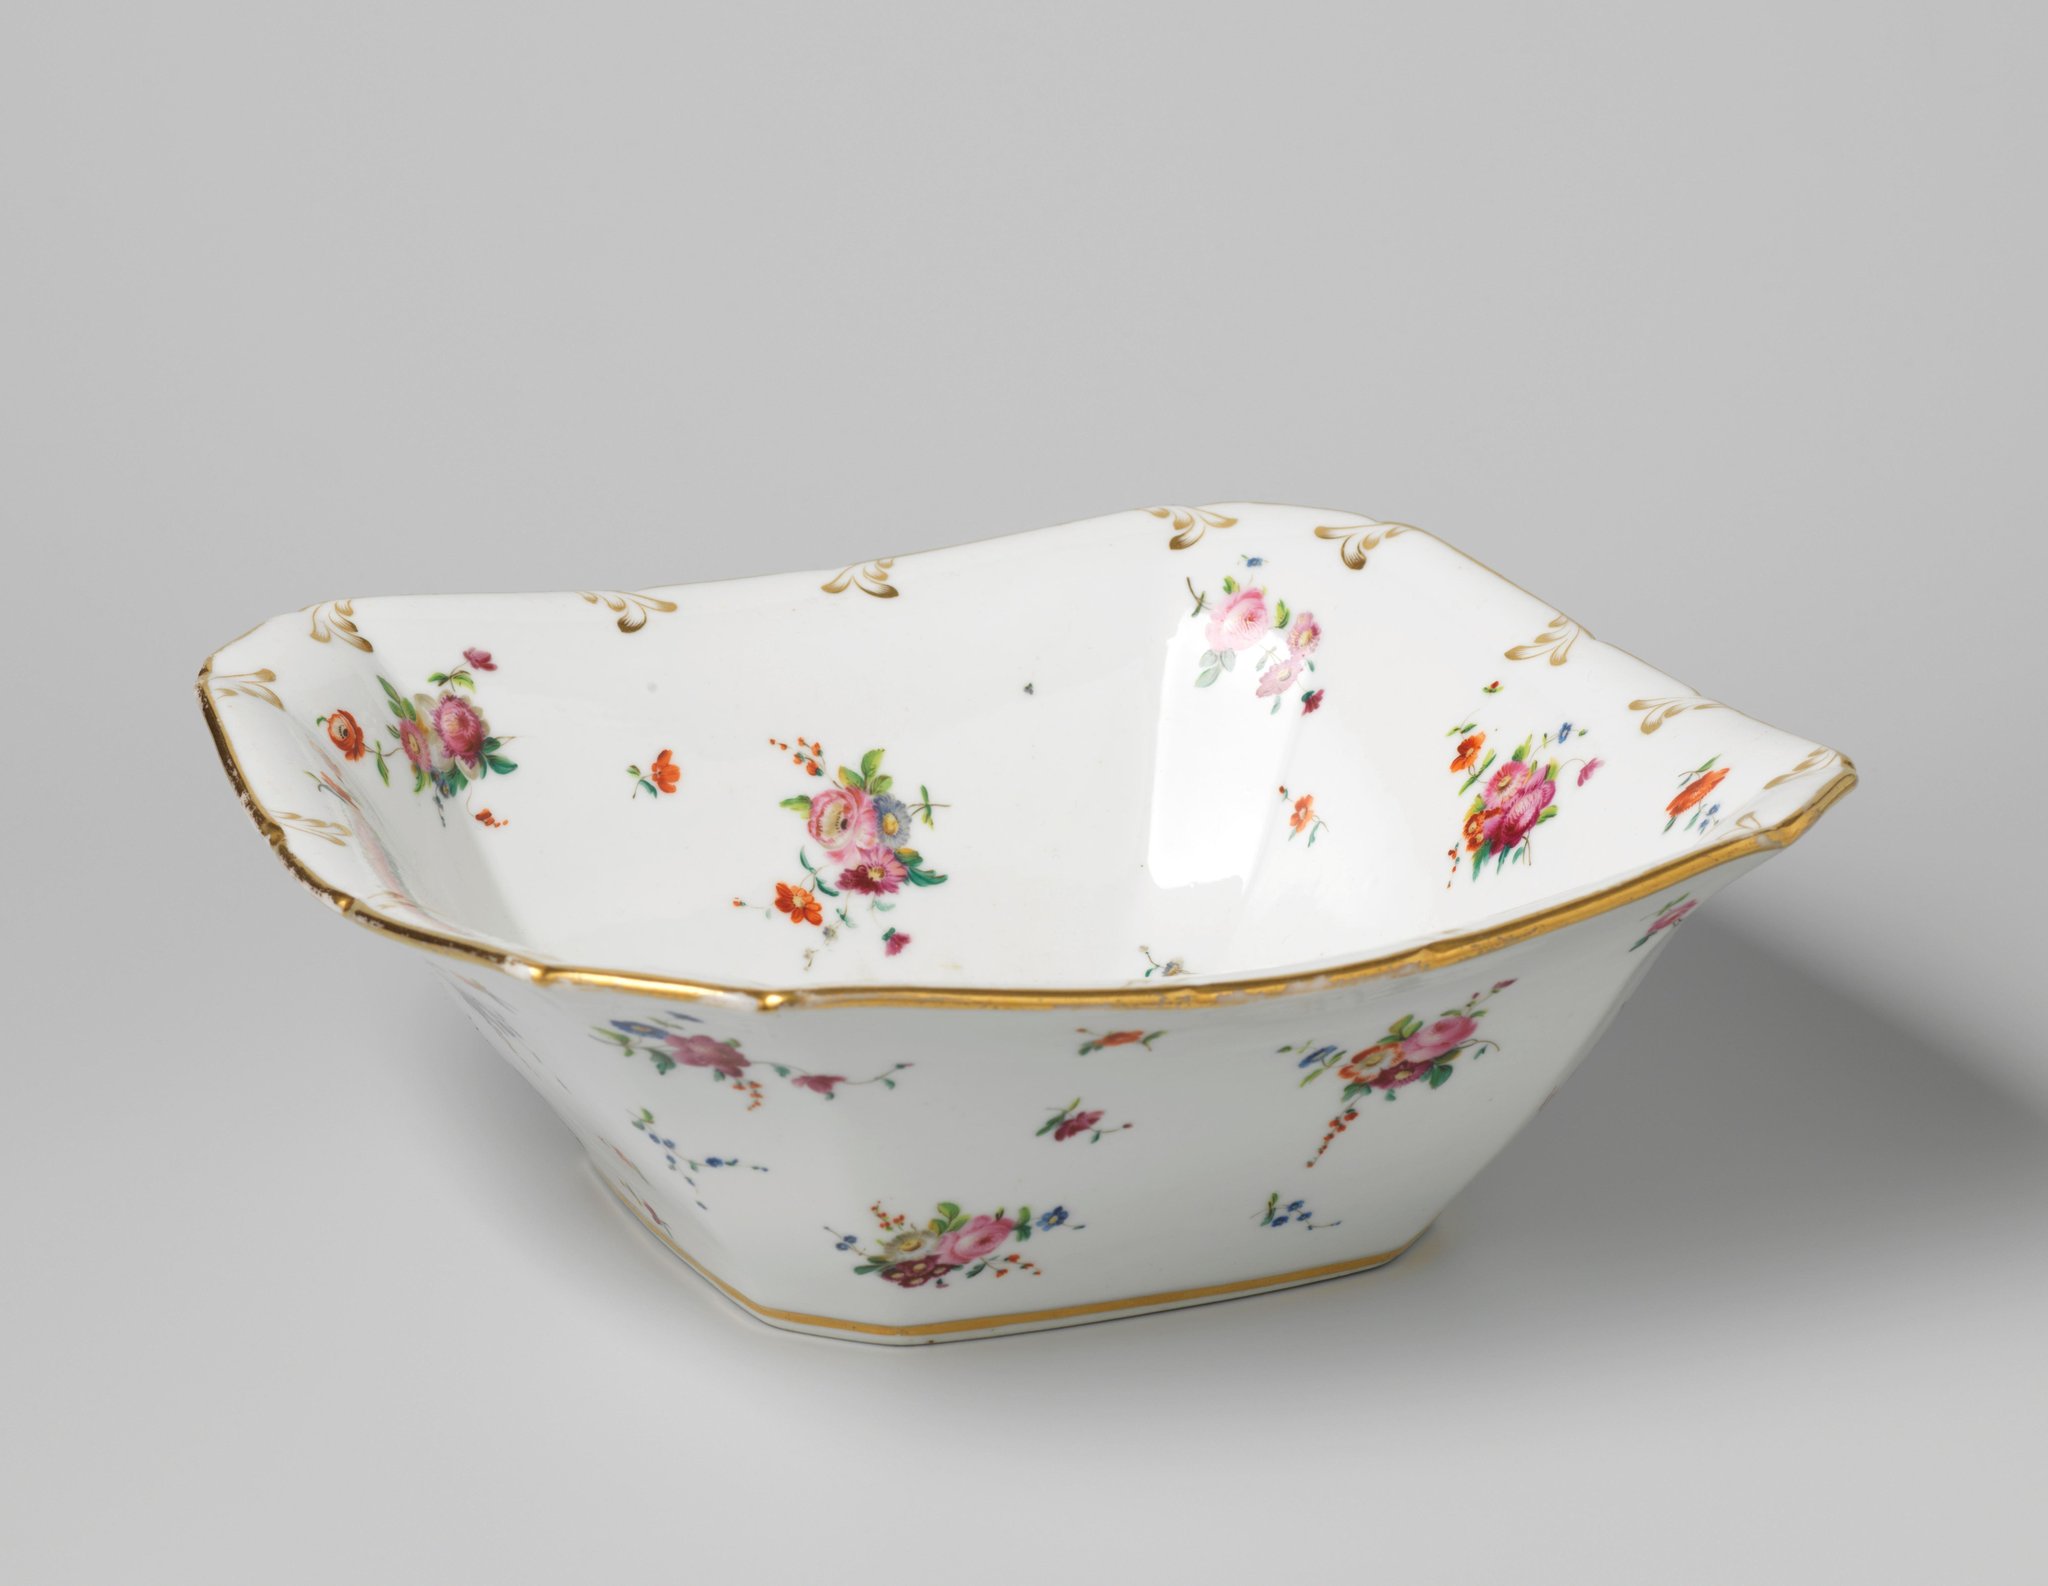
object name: dish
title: Dish with bouquets and flower sprays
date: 1839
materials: glaze, gold, paint, porcelain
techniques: firing, forming, gilding, turning, vitrification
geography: paris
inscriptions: mark: ‘DENUELLE/ Boulevard St. Denis 18/ à Paris’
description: Vierkante schaal van porselein met een gelobde rand en afgeschuinde hoeken, beschilderd op het glazuur in blauw, rood, roze, groen, geel, paars, zwart en goud. Op de binnen- en buitenzijde versierd met boeketten van verschillende bloemen en strooibloemen. Vanuit de gelobde, gouden rand, geschilderde gouden bladranken. Een proen op de onderzijde. Gemerkt op de onderzijde met 'DENUELLE/ Boulevard St. Denis 18/ à Paris'.